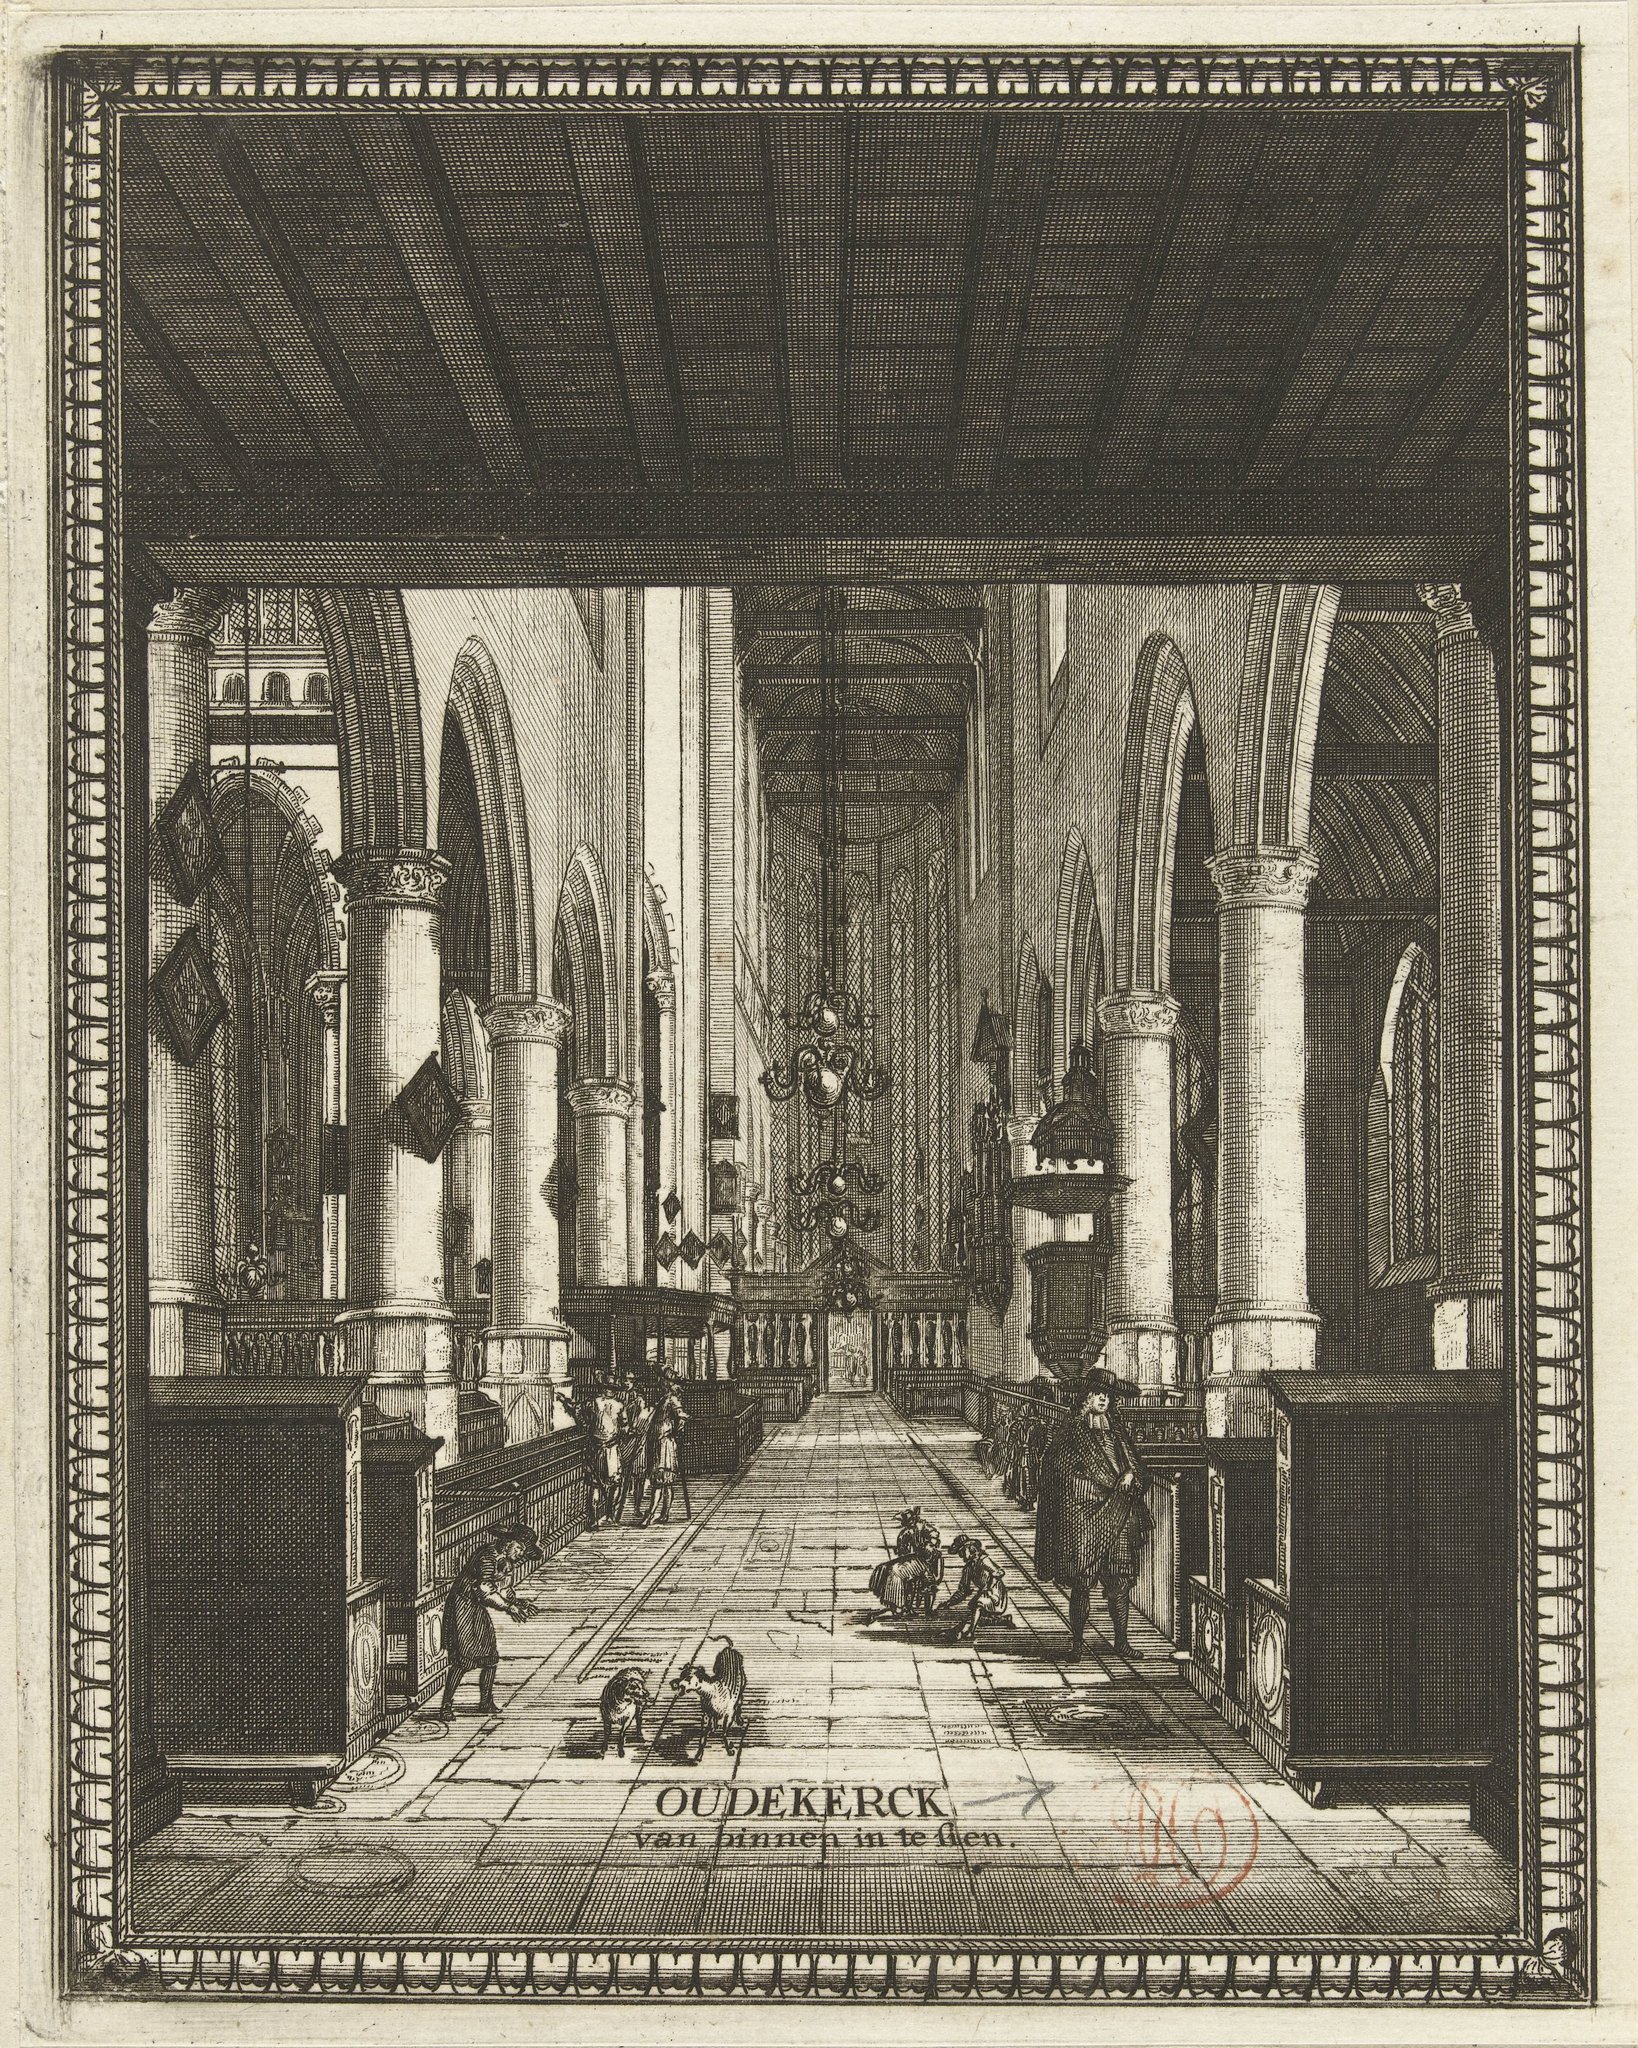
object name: book illustration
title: Interieur van de Oude Kerk te Delft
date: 1680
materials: paper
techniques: etching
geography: amsterdam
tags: interior of church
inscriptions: collector's mark: Lugt 2228, collector's mark: Lugt 195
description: Prent ook gebruikt in: Bleyswijck, Dirk Evertsz. Beschryvinge der stadt Delft, betreffende des selfs situatie, oorsprong en ouderdom, opkomst en voortgangh (…). Delft: Arnold Bon, 1667 (prenten vanaf 1680 ingebonden), p. 174. Hoewel deze publicatie al in 1667 werd uitgegeven, zijn de bijhorende prenten pas in 1680, tegelijkertijd met het tweede deel ('Vervolg van de beschryvinge der stadt Delft'), verschenen. In het tweede deel zat een bijlage waarin beschreven staat welke prenten waar in het eerste en tweede deel ingebonden dienden te worden. Zodoende zijn de prenten uit het eerste deel dus pas in of na 1680 ingebonden. Hierdoor wordt vaak gedacht dat de prenten uit het eerste deel dateren uit 1667, hetgeen niet klopt. De prenten werden geleverd door drukker/uitgever Pieter Smith.